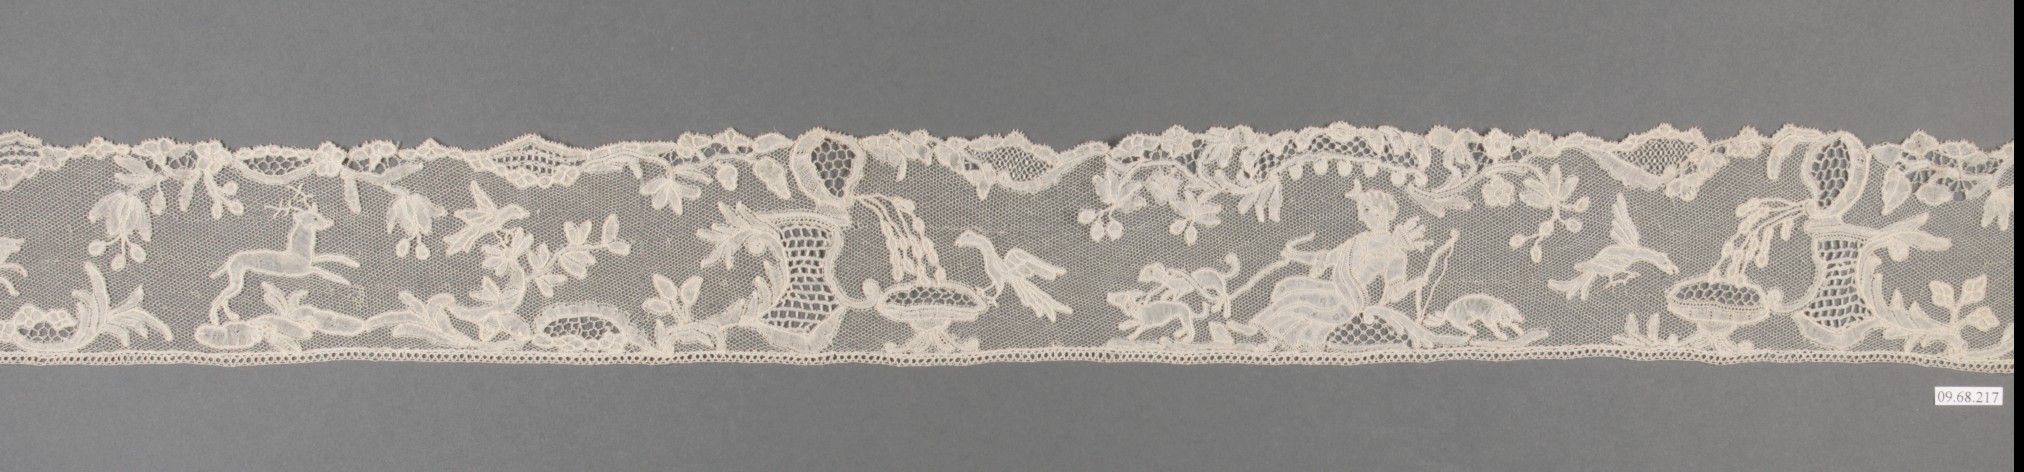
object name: strip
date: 1701-1800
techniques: lace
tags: human figures,birds,bow and arrow,deer